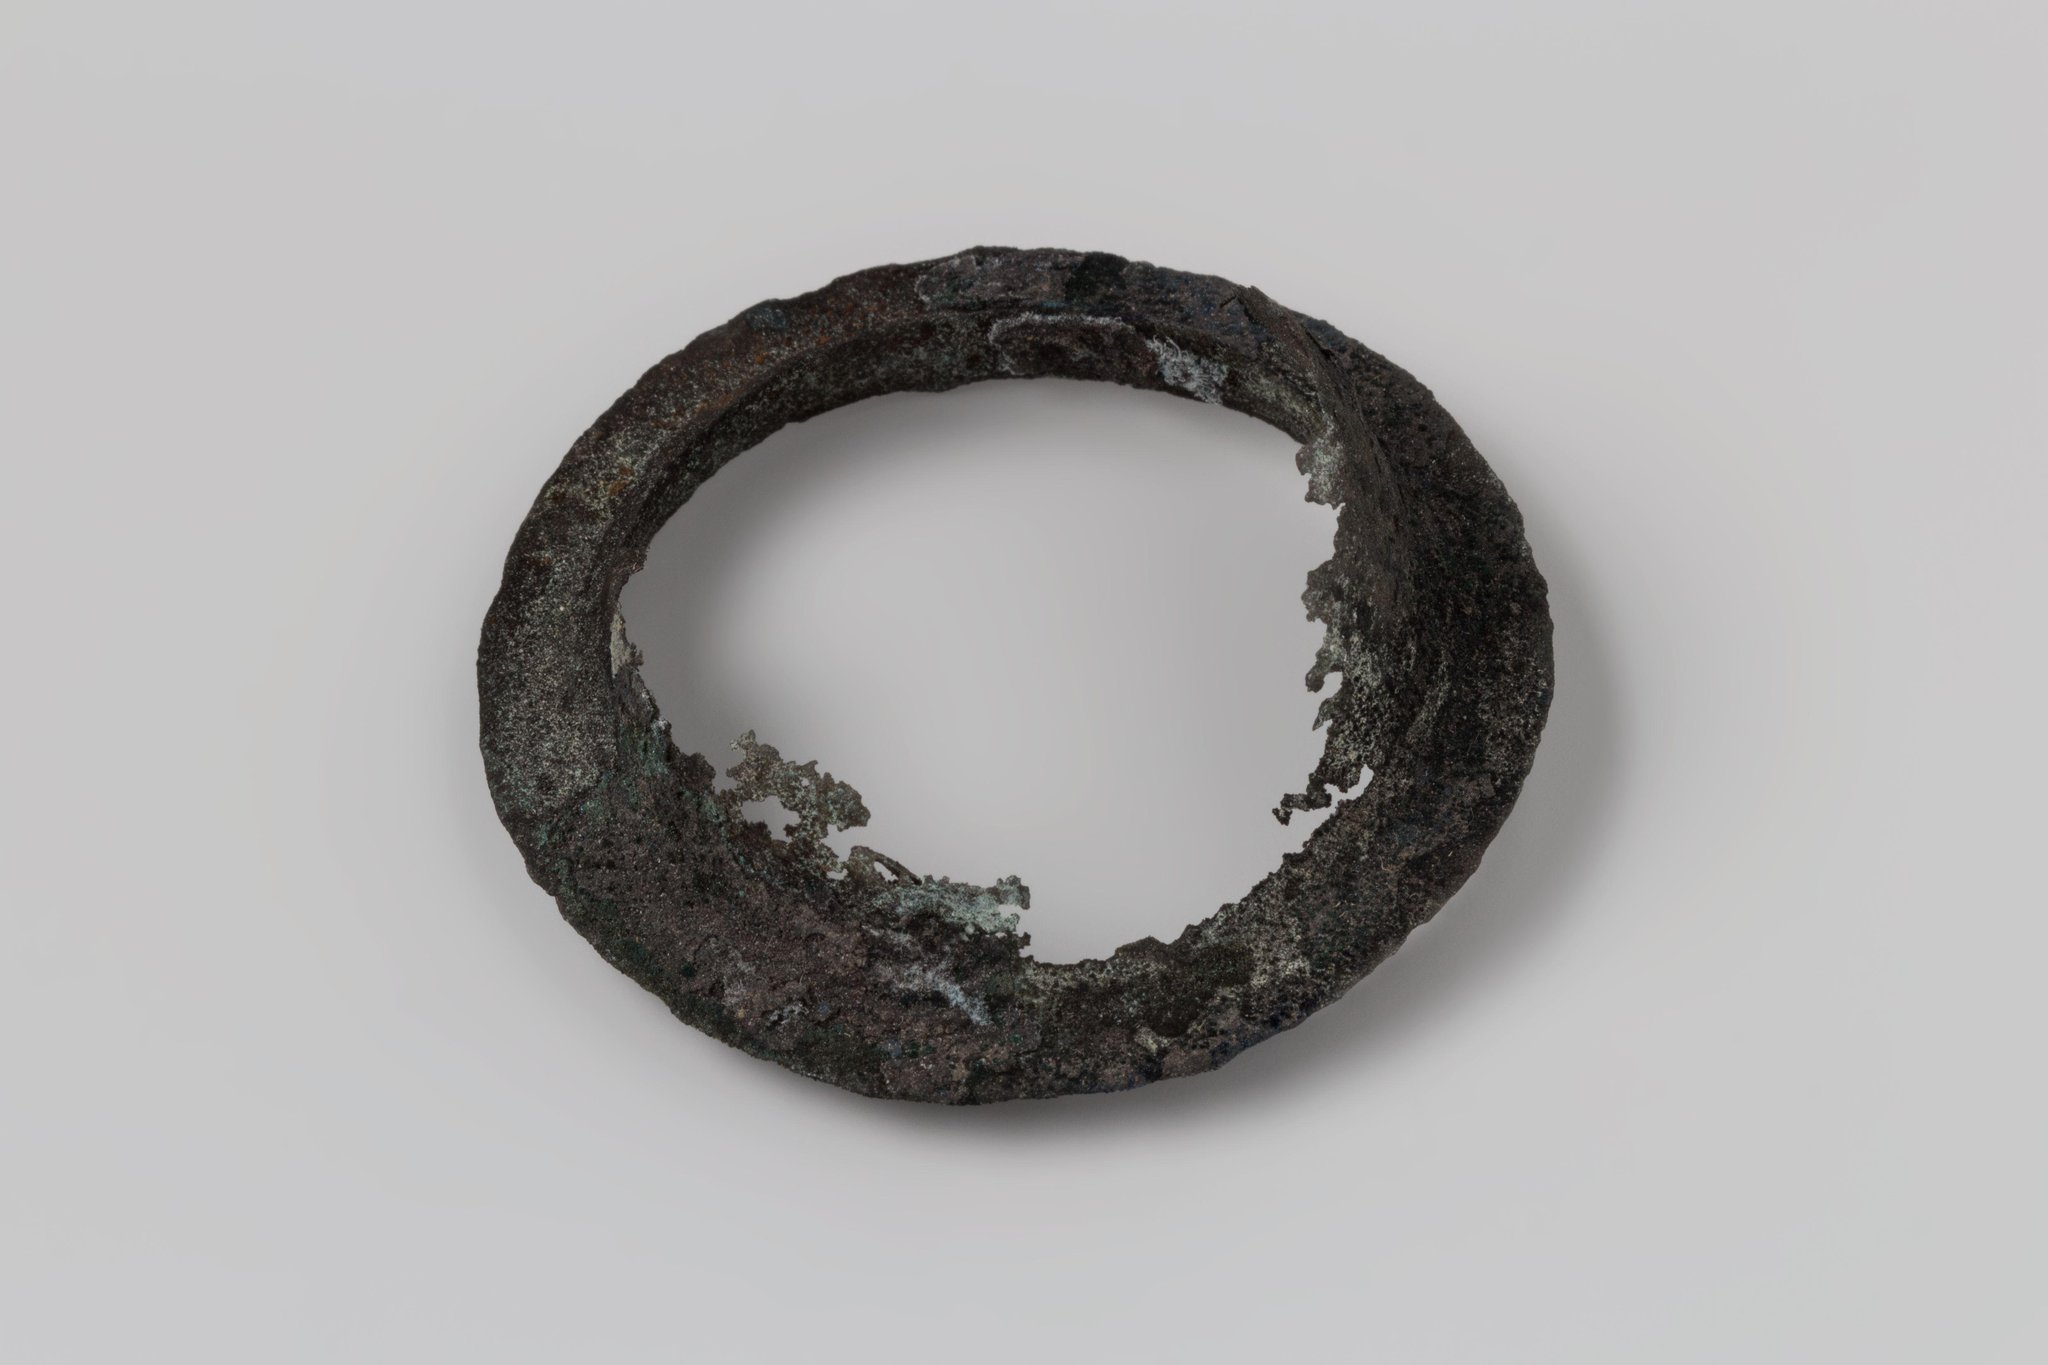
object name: ring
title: Ring van metaal uit V.O.C.-schip de 'Witte Leeuw'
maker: Anonymous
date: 1613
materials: metal